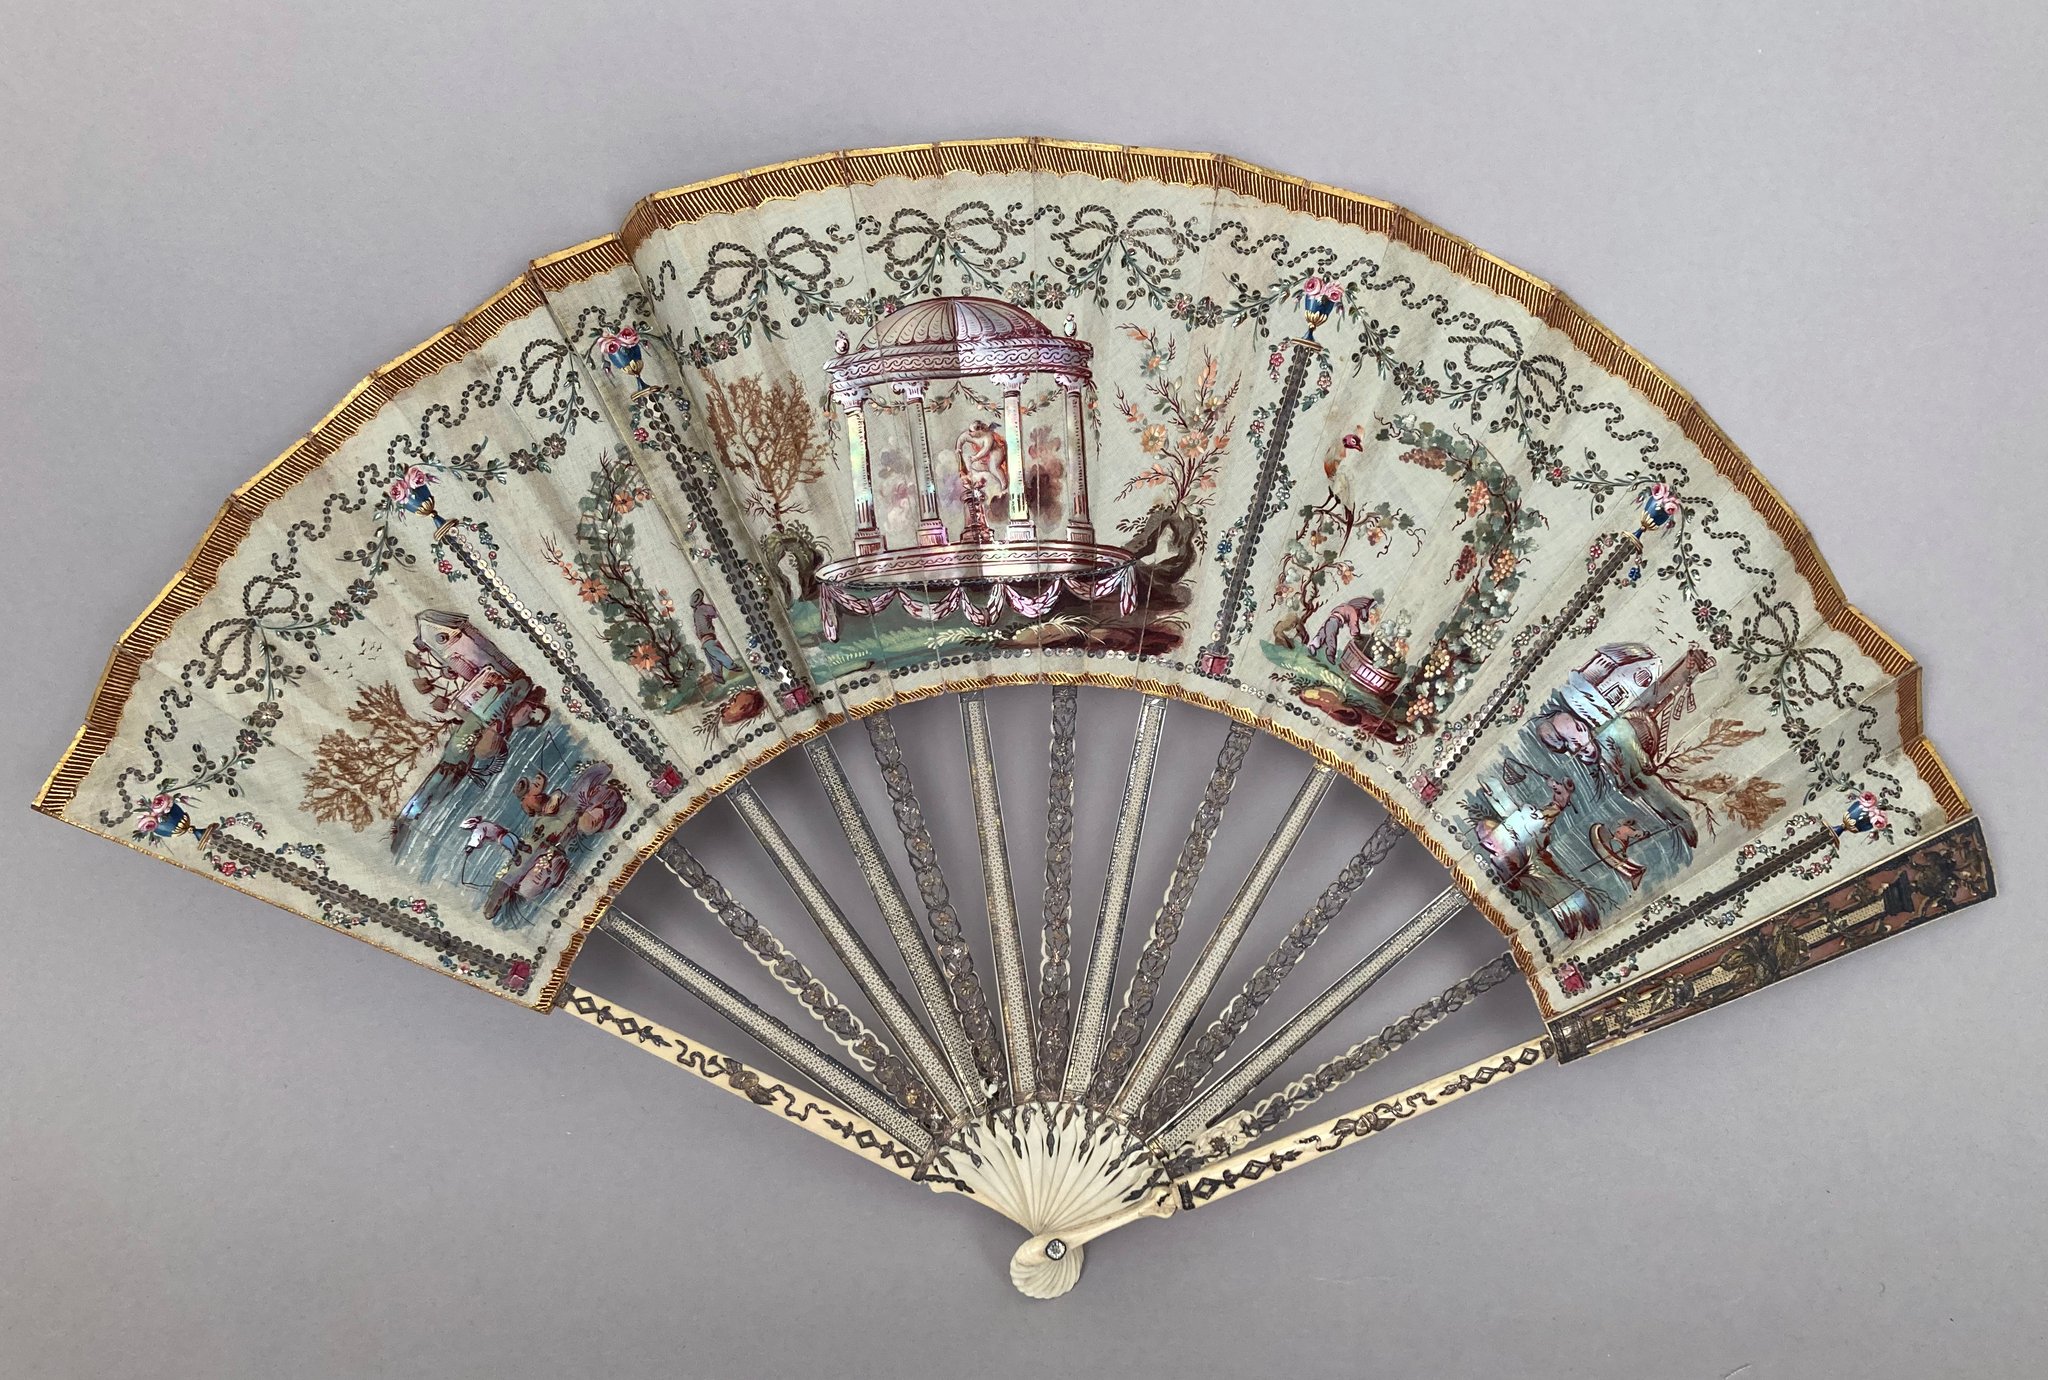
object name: fan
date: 1776-1800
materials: ivory, mother of pearl, silk